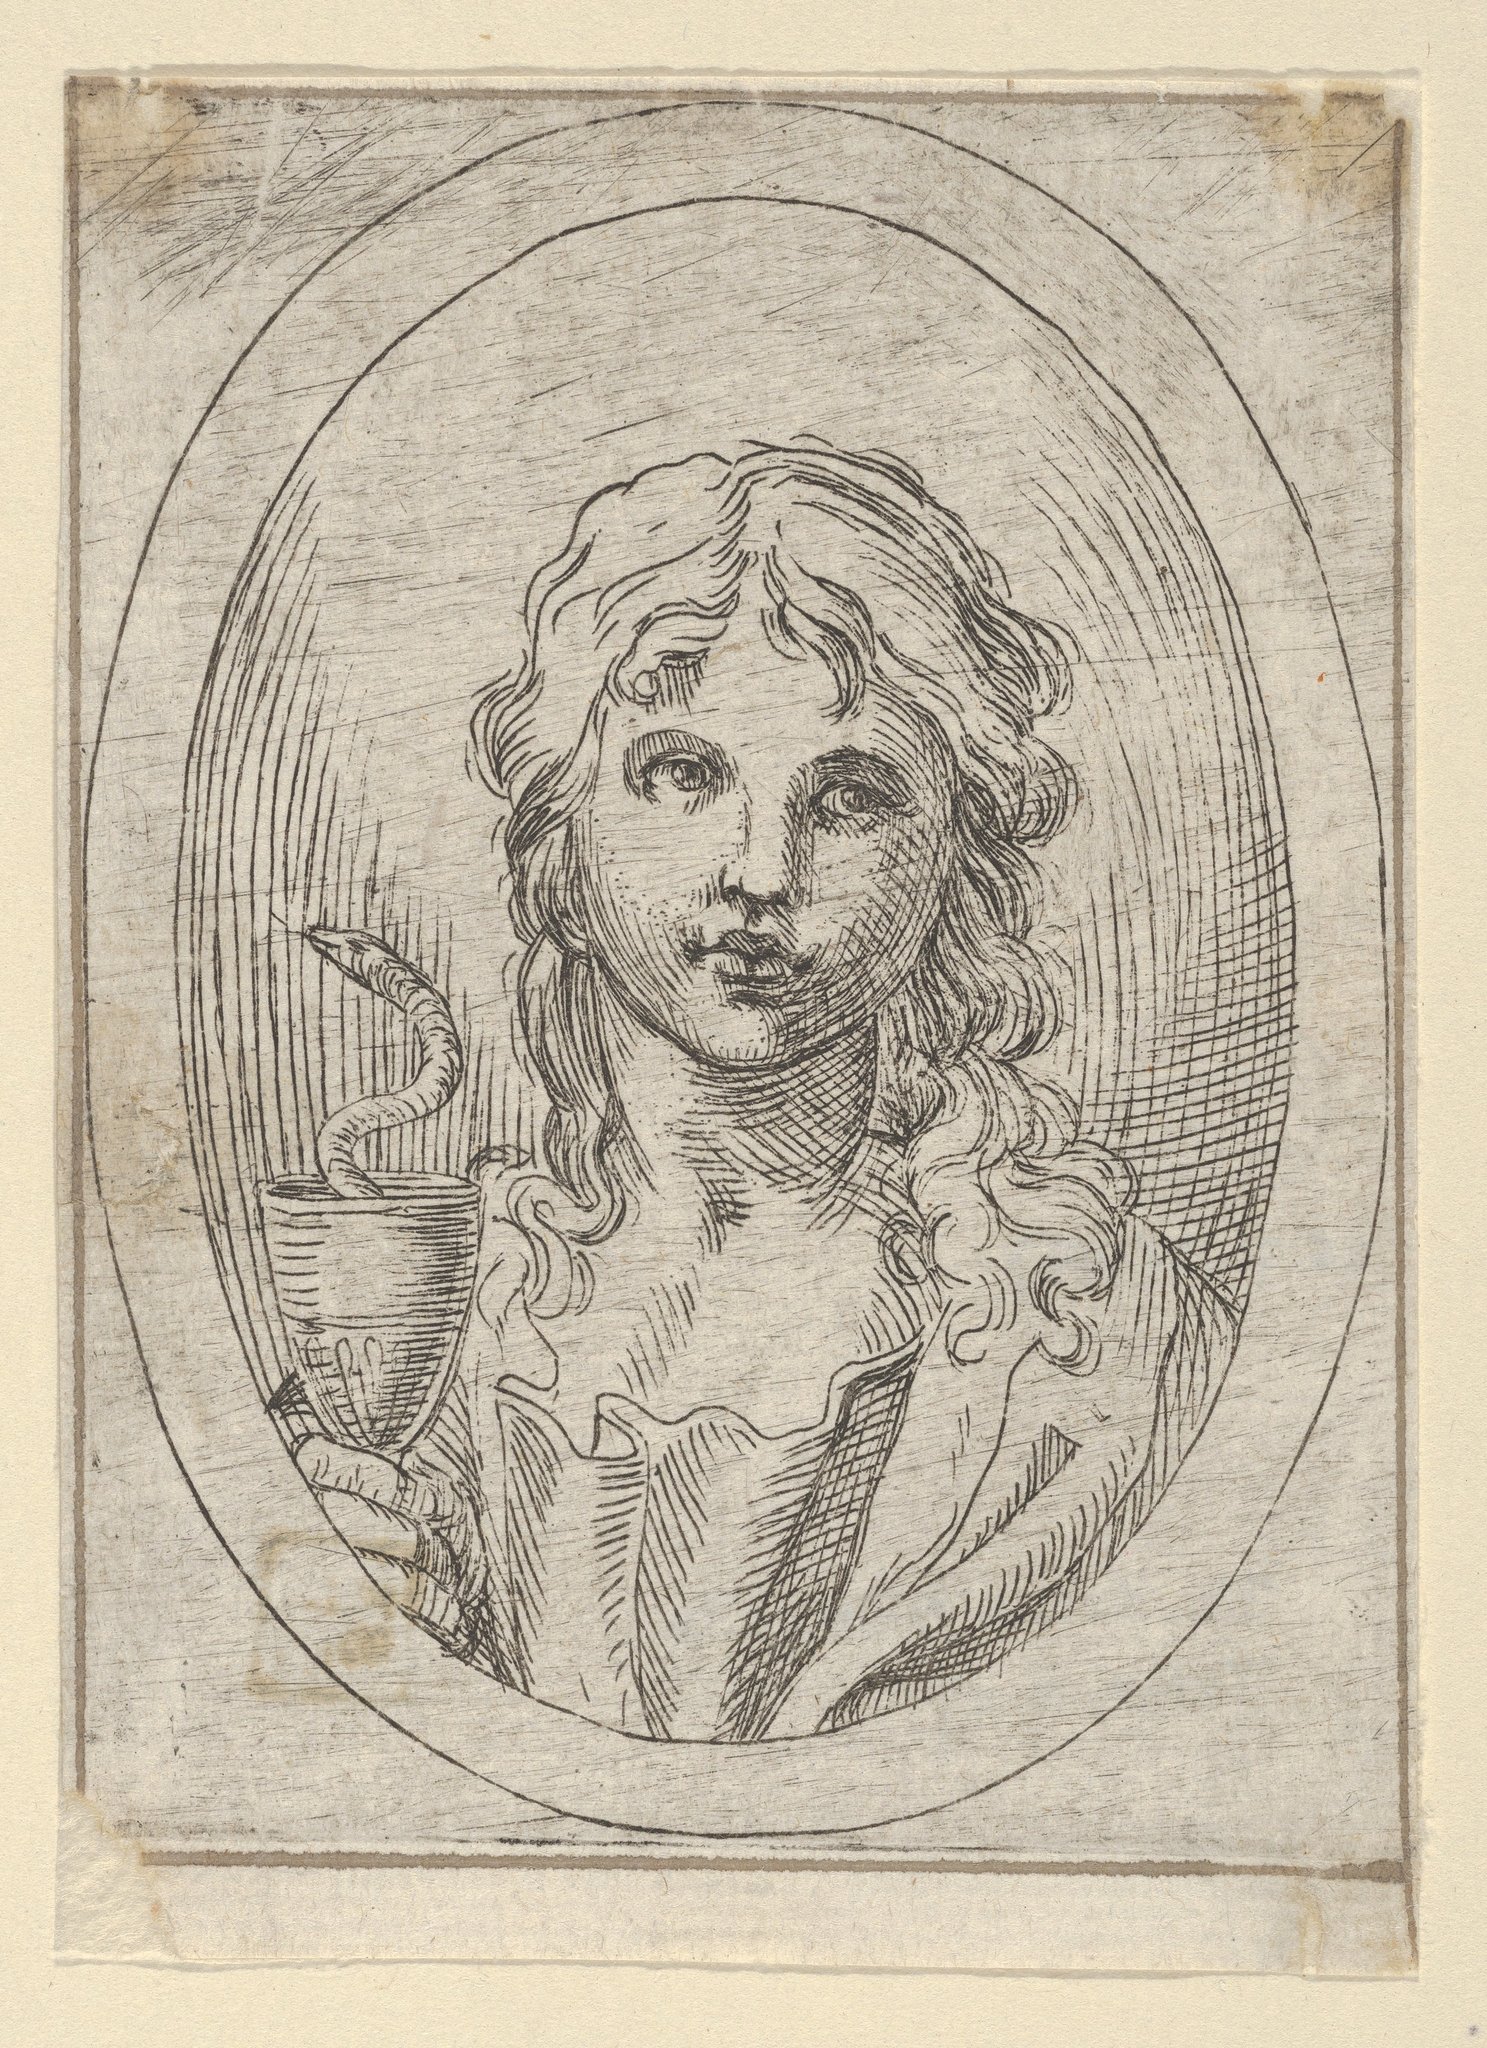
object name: print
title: Saint John the Evangelist holding a goblet with a snake emerging from it, from "Christ, the Virgin, and Thirteen Apostles"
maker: anonymous, 17th century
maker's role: artist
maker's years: 1600-1700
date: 1600-1640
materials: ink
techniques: etching, pen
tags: portraits,snakes,saint john the evangelist,drinking glasses